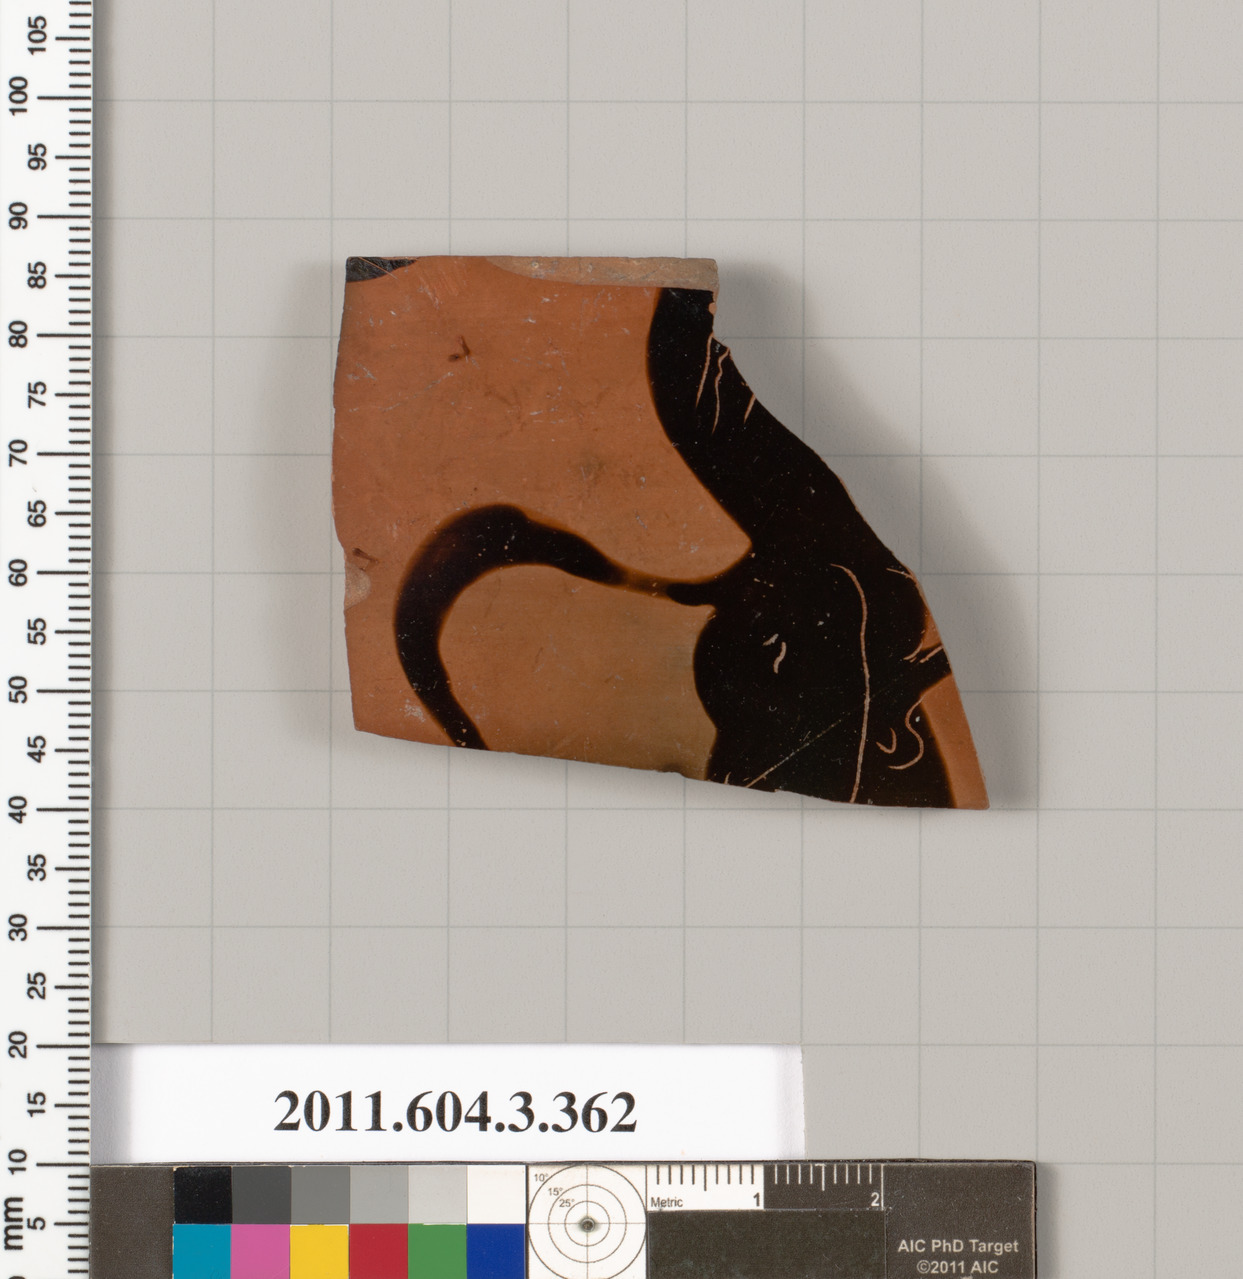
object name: neck amphora fragment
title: Terracotta fragment of a neck-amphora (jar)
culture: greek, attic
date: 534-468 BCE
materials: terracotta